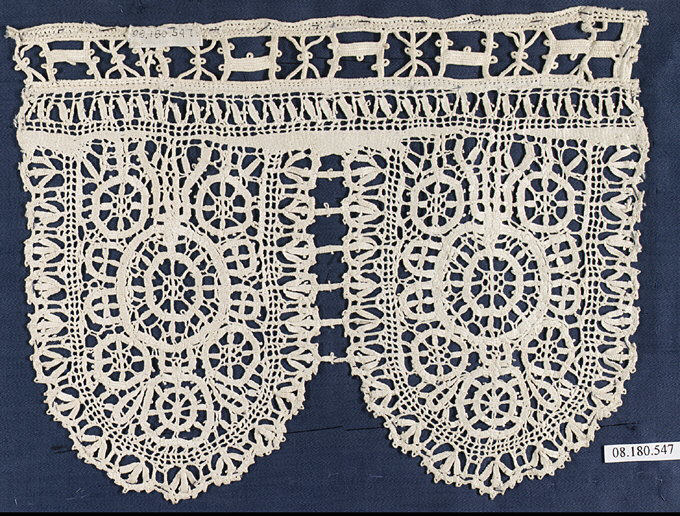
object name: fragment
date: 1701-1800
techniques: lace